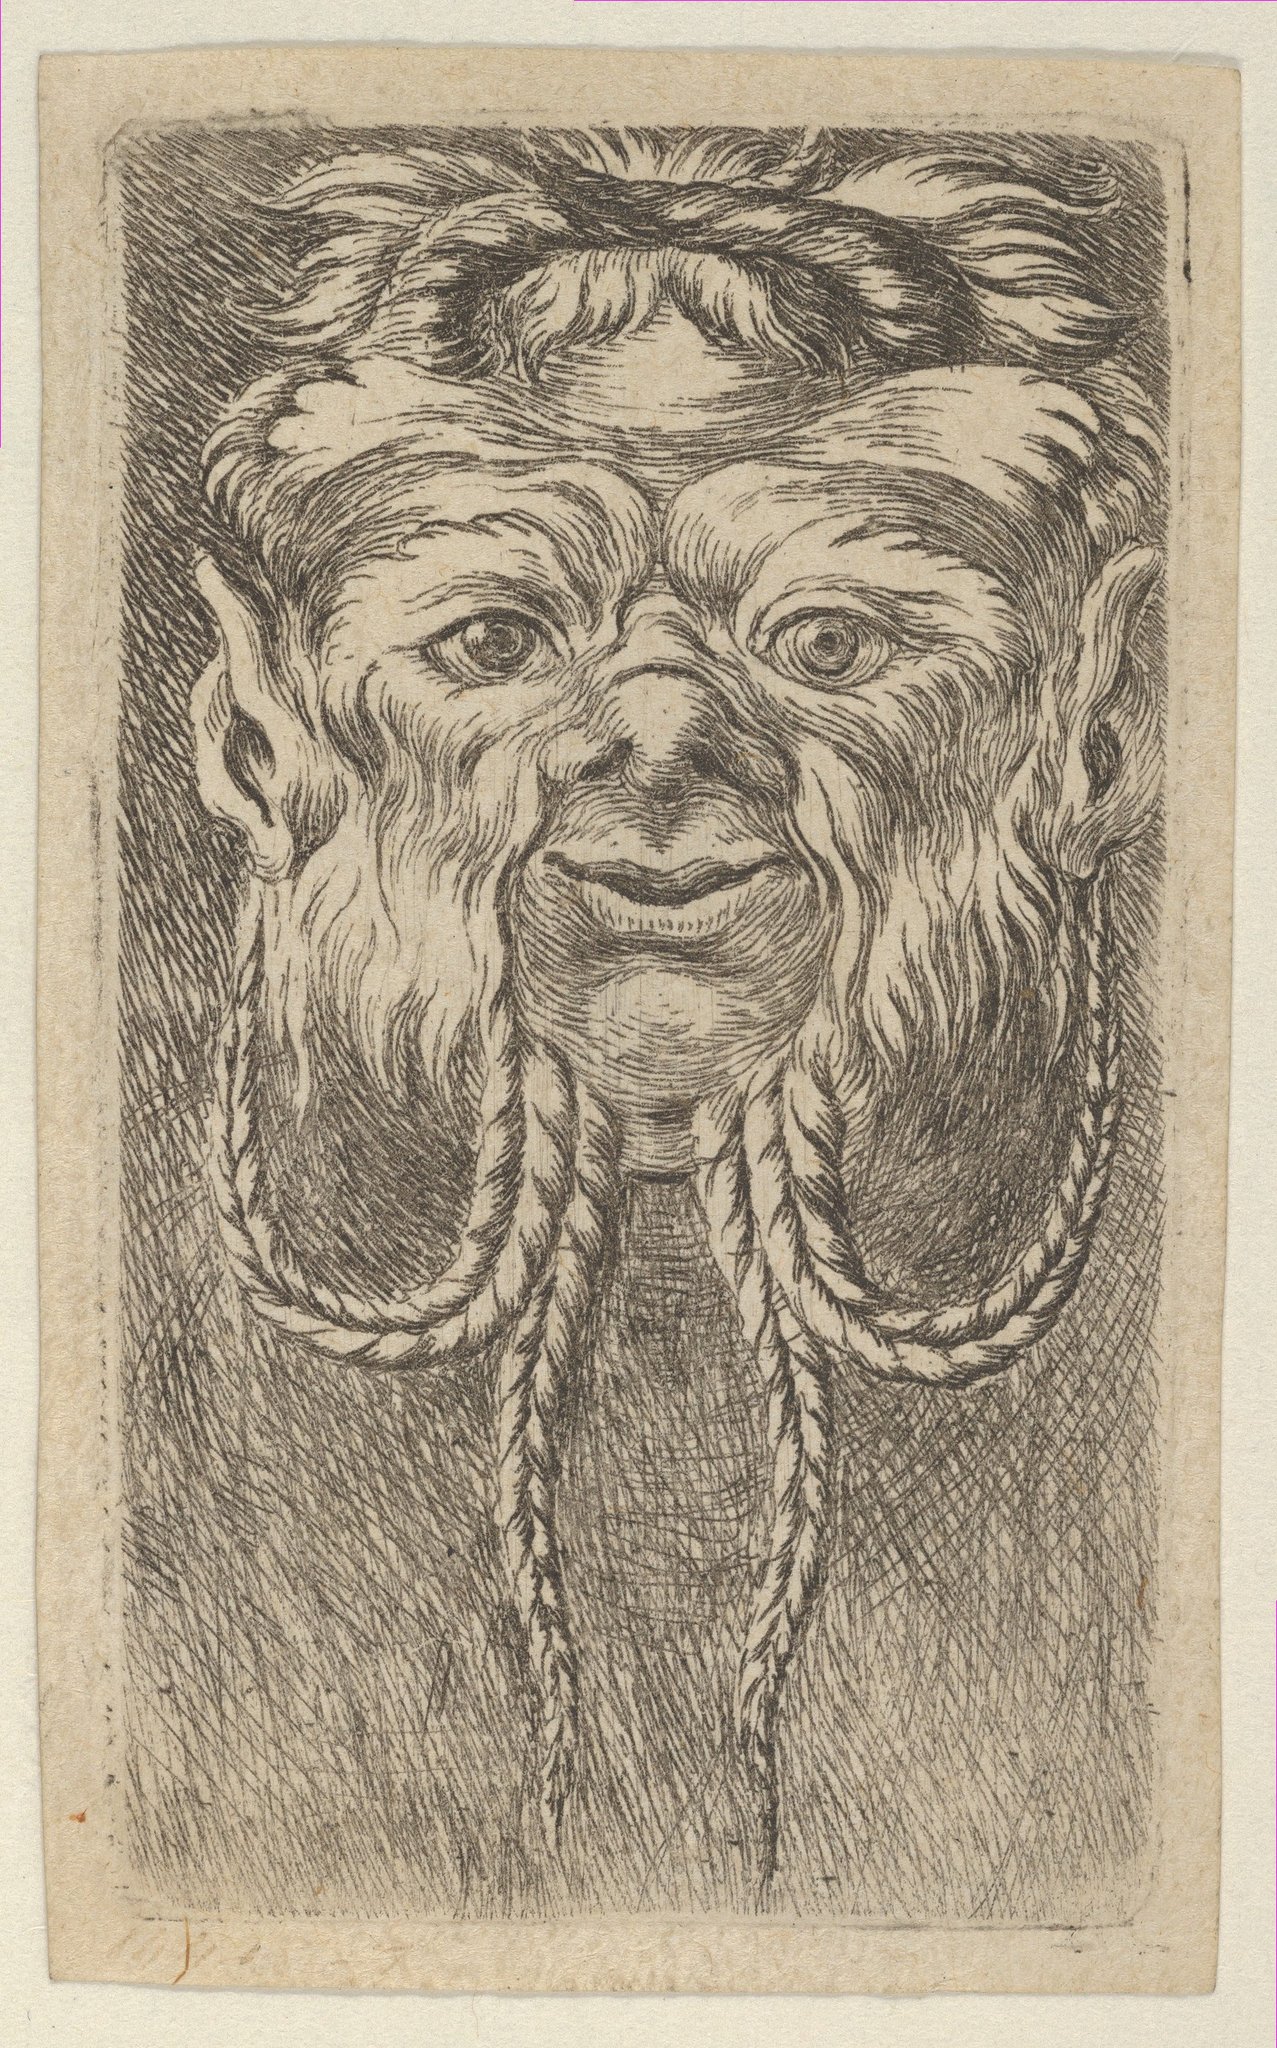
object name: print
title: Satyr Mask with Overlapping Horns and Four Braided Strands of Beard, from "Divers Masques"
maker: françois chauveau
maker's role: artist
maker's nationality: french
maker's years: 1613-1676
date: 1635-1645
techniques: etching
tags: masks,satyrs